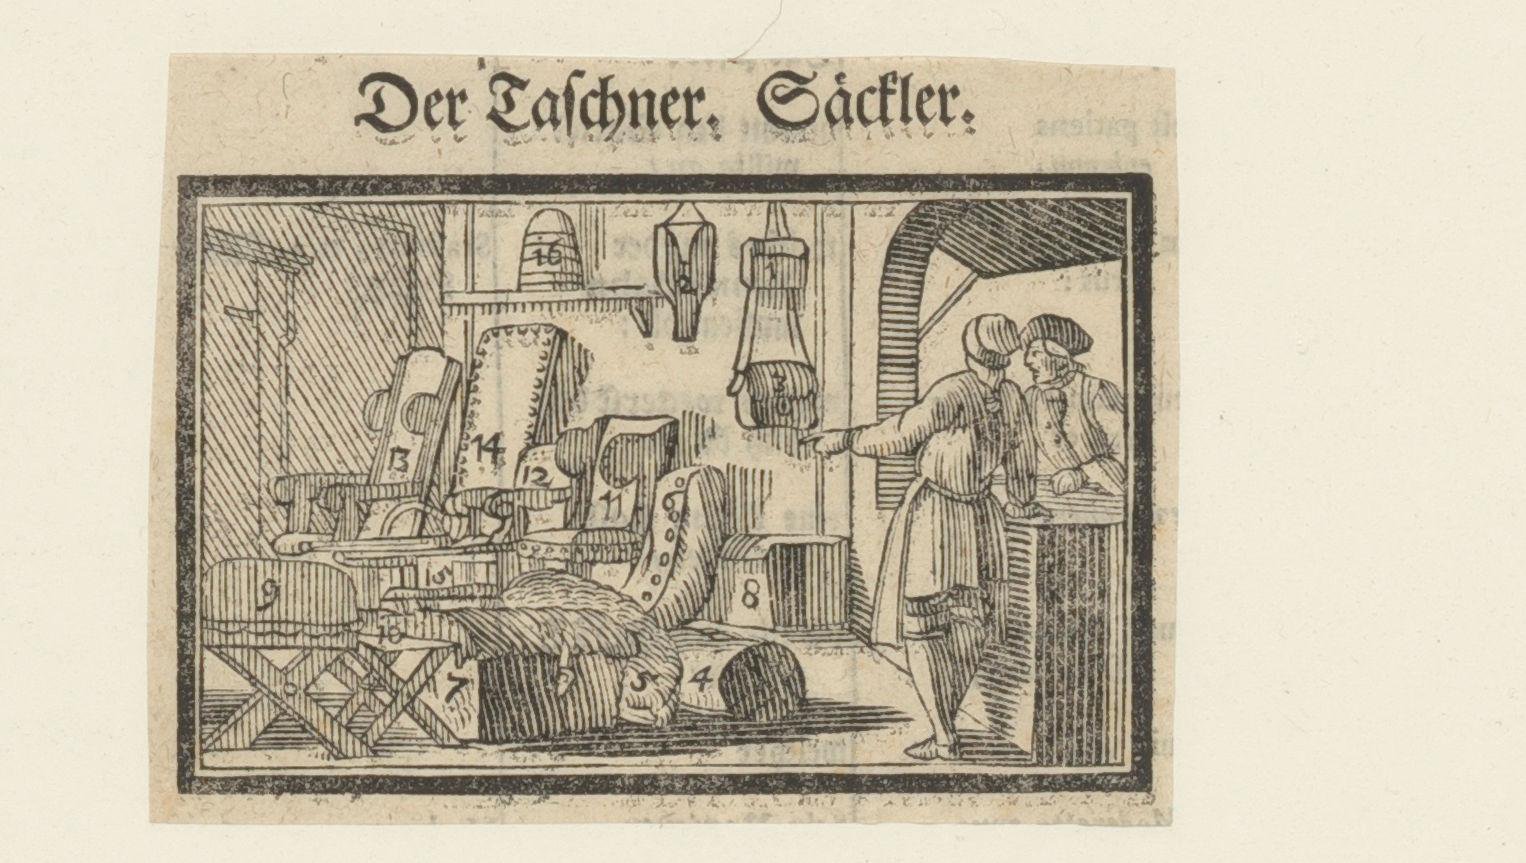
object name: book illustration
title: Takken- en zakkenmaker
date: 1719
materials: paper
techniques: letterpress printing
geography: nuremberg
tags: purse, money-bag, handicrafts, craftsman at work, leather industry, bag, container of leather: leather bag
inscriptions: collector's mark: Lugt 1641, stamp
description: Prent uit: Comenius, Johannes Amosius. Orbis sensualium picti pars prima (...). Neurenberg: Martin Endter, 1719, dl. 2, p. 216. Prent eerder gebruikt in: Comenius, Johannes Amosius. Orbis Sensualium Picti denuo aucti Pars Secunda (...). Neurenberg: Martin Endter, 1730, dl. 2.